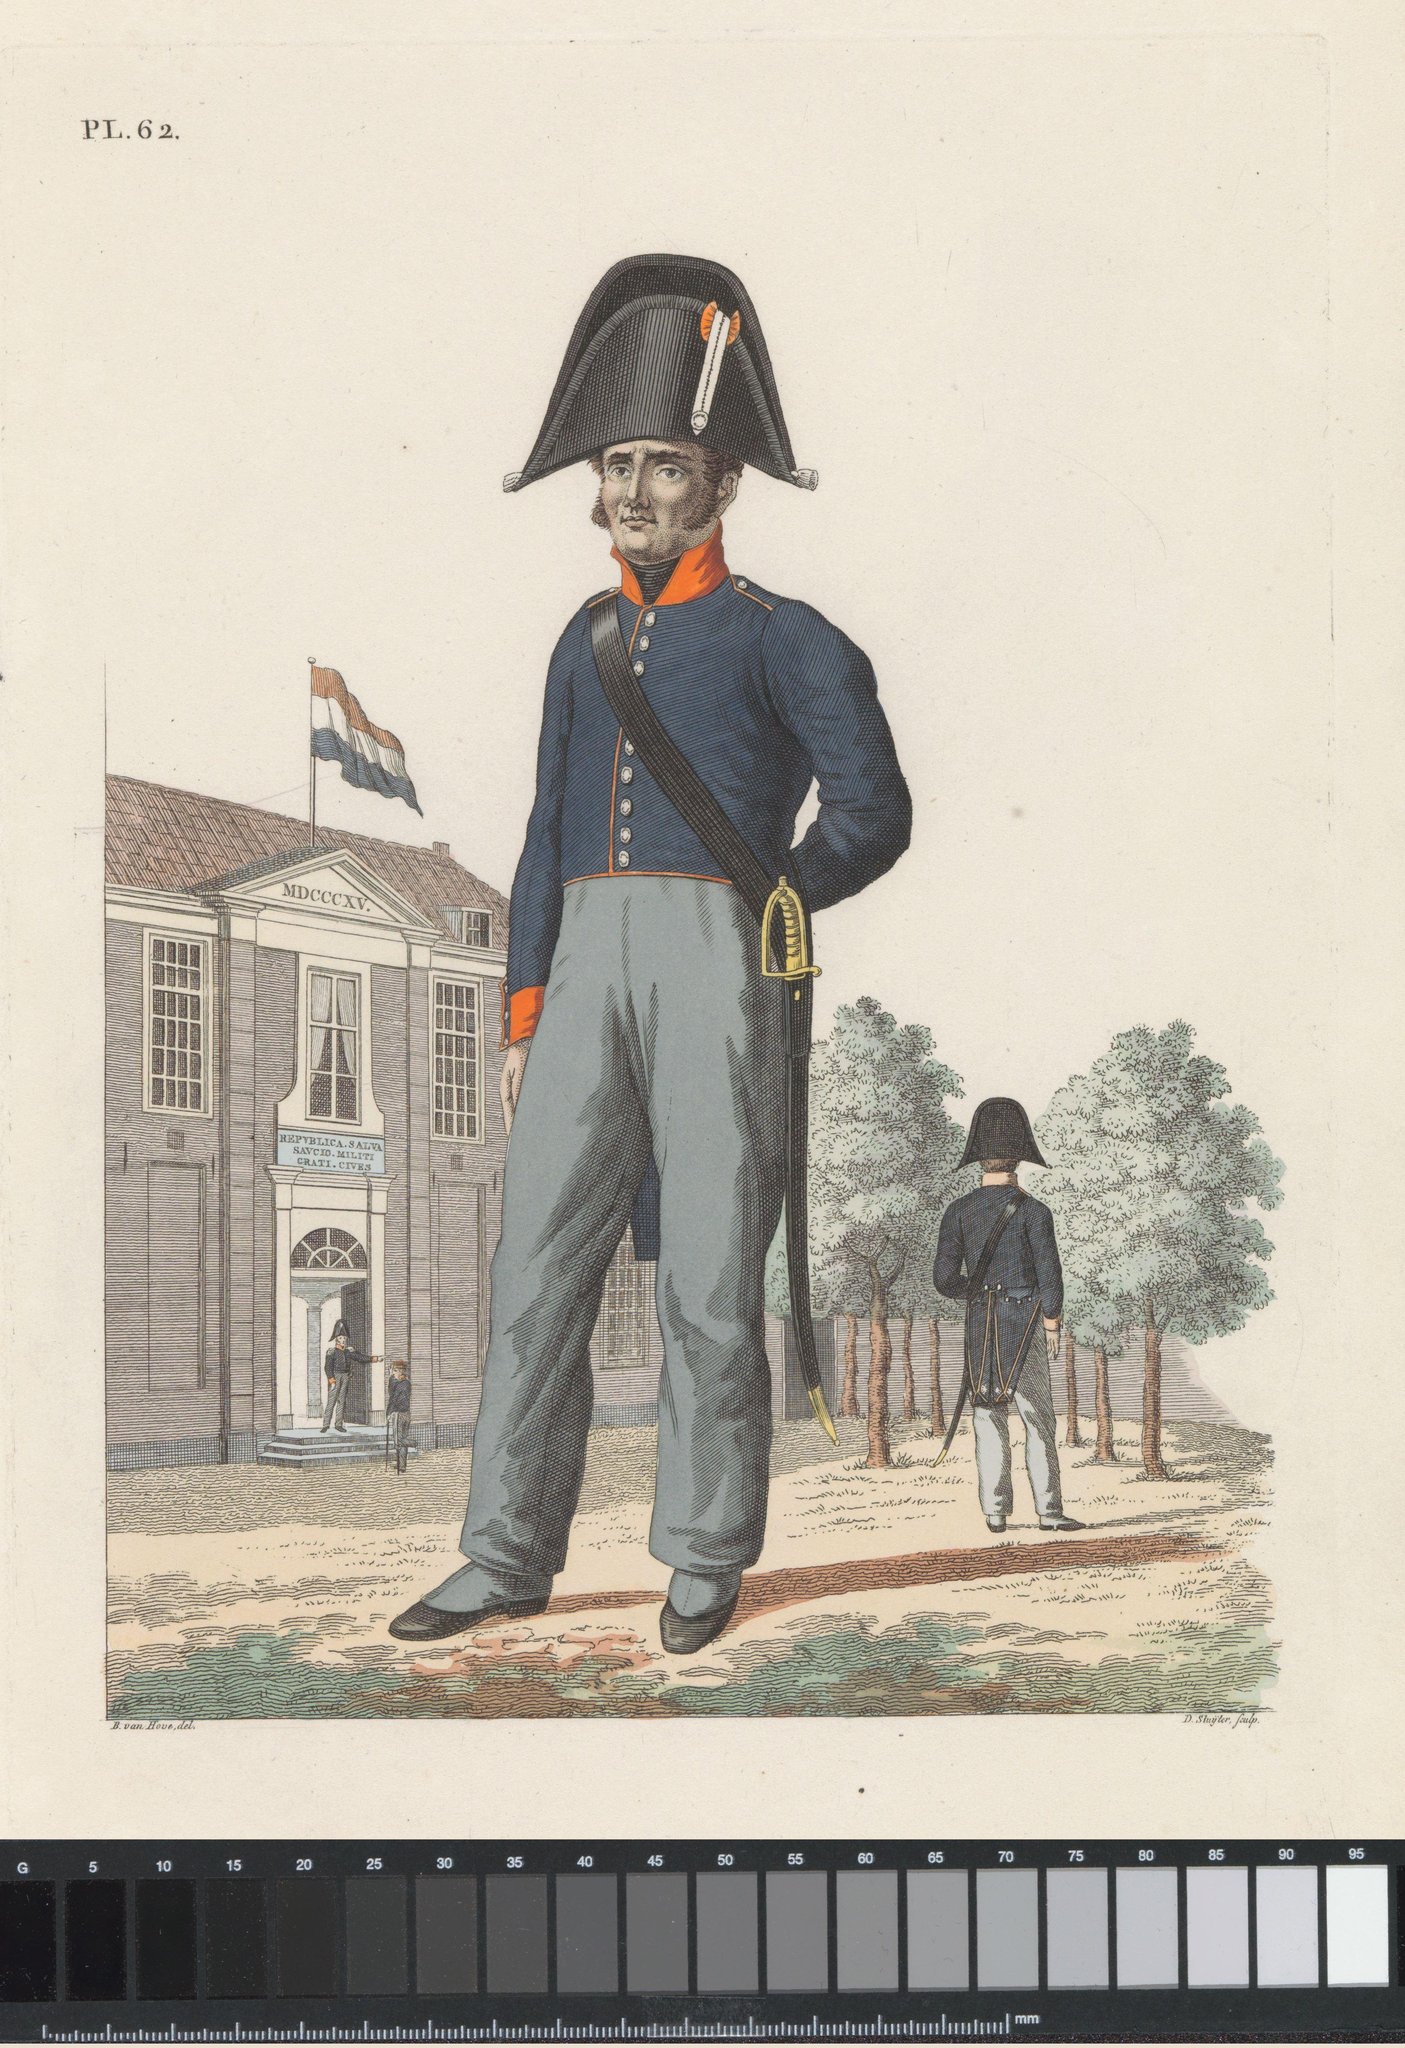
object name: costume print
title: Invaliden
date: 1826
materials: paper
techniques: engraving, etching, hand coloring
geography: the hague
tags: (military) uniforms, leiden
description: Een Nederlandse invalide militair staande voor het Militair Invalidenhuis te Leiden. Plaat 62. Uniformvoorstelling in 'Vervolg van de Beschrijving hoedanig de Koninklijke Nederlandsche troepen' van J.F. Teupken, 1826.